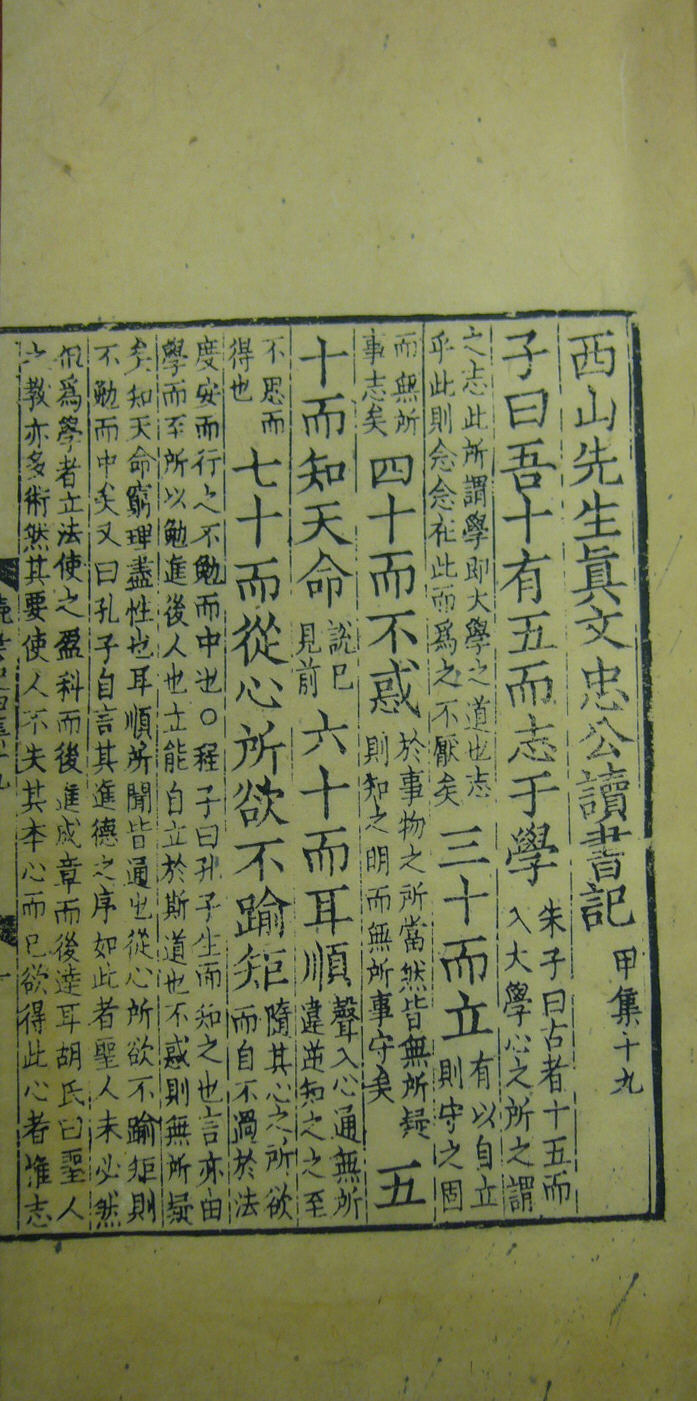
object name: illustrated book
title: Sample of Chinese printing of the Song period (960–1278)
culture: chinese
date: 960-1278